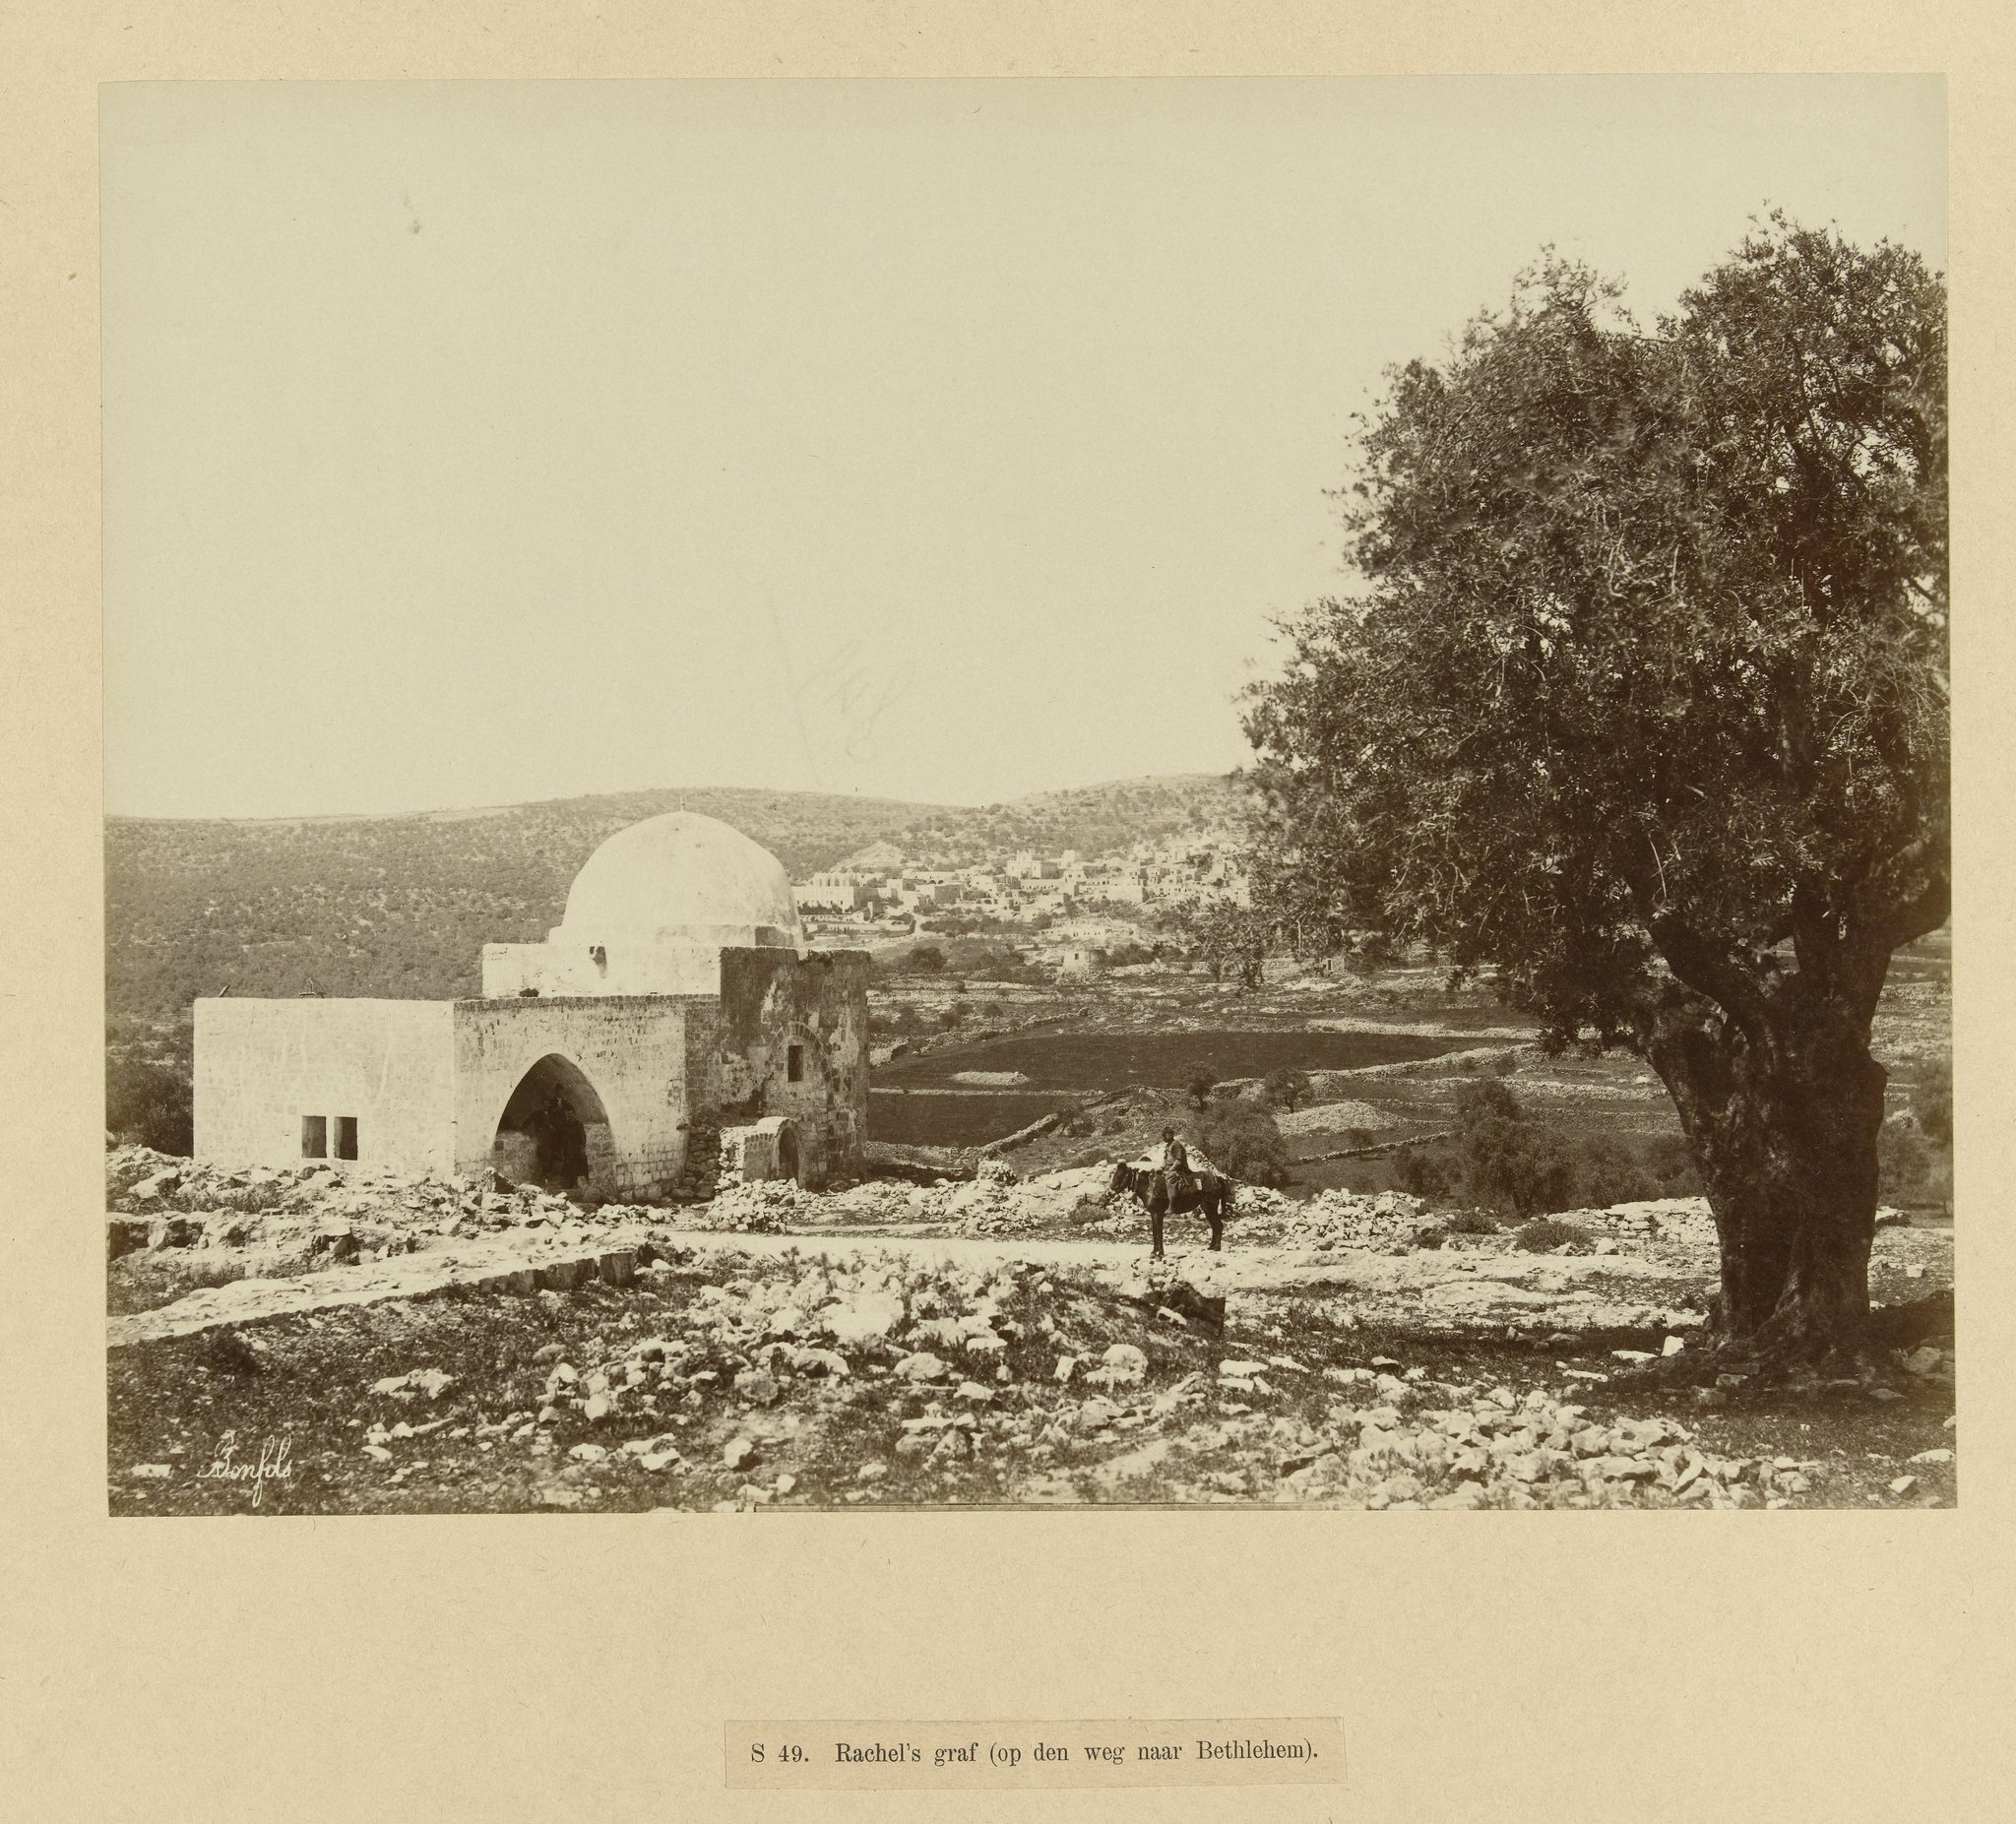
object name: photograph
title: S 49. Rachel's graf (op den weg naar Bethlehem)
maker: félix bonfils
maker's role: fotograaf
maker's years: 1831-1885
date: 1867-1877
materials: cardboard, paper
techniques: albumen print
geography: ottoman empire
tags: grave, tomb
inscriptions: title: ‘S 49. Rachel's graf (op den weg naar Bethlehem).’, check stamp: ‘Bristol/ L.M.’, stamp: ‘Gemeentelijke bibliotheek/ Rotterdam’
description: Onderdeel van een groep door fotograaf Richard Polak op reis verzamelde foto’s. Deze foto is samen met andere op zijn reizen verzamelde foto's tentoongesteld bij de Rotterdamsche Kunstkring (1895), Arti en Amicitiae te Amsterdam (1897-1898?) en Societeit 't Collegie te Kampen (datum vooralsnog onbekend).